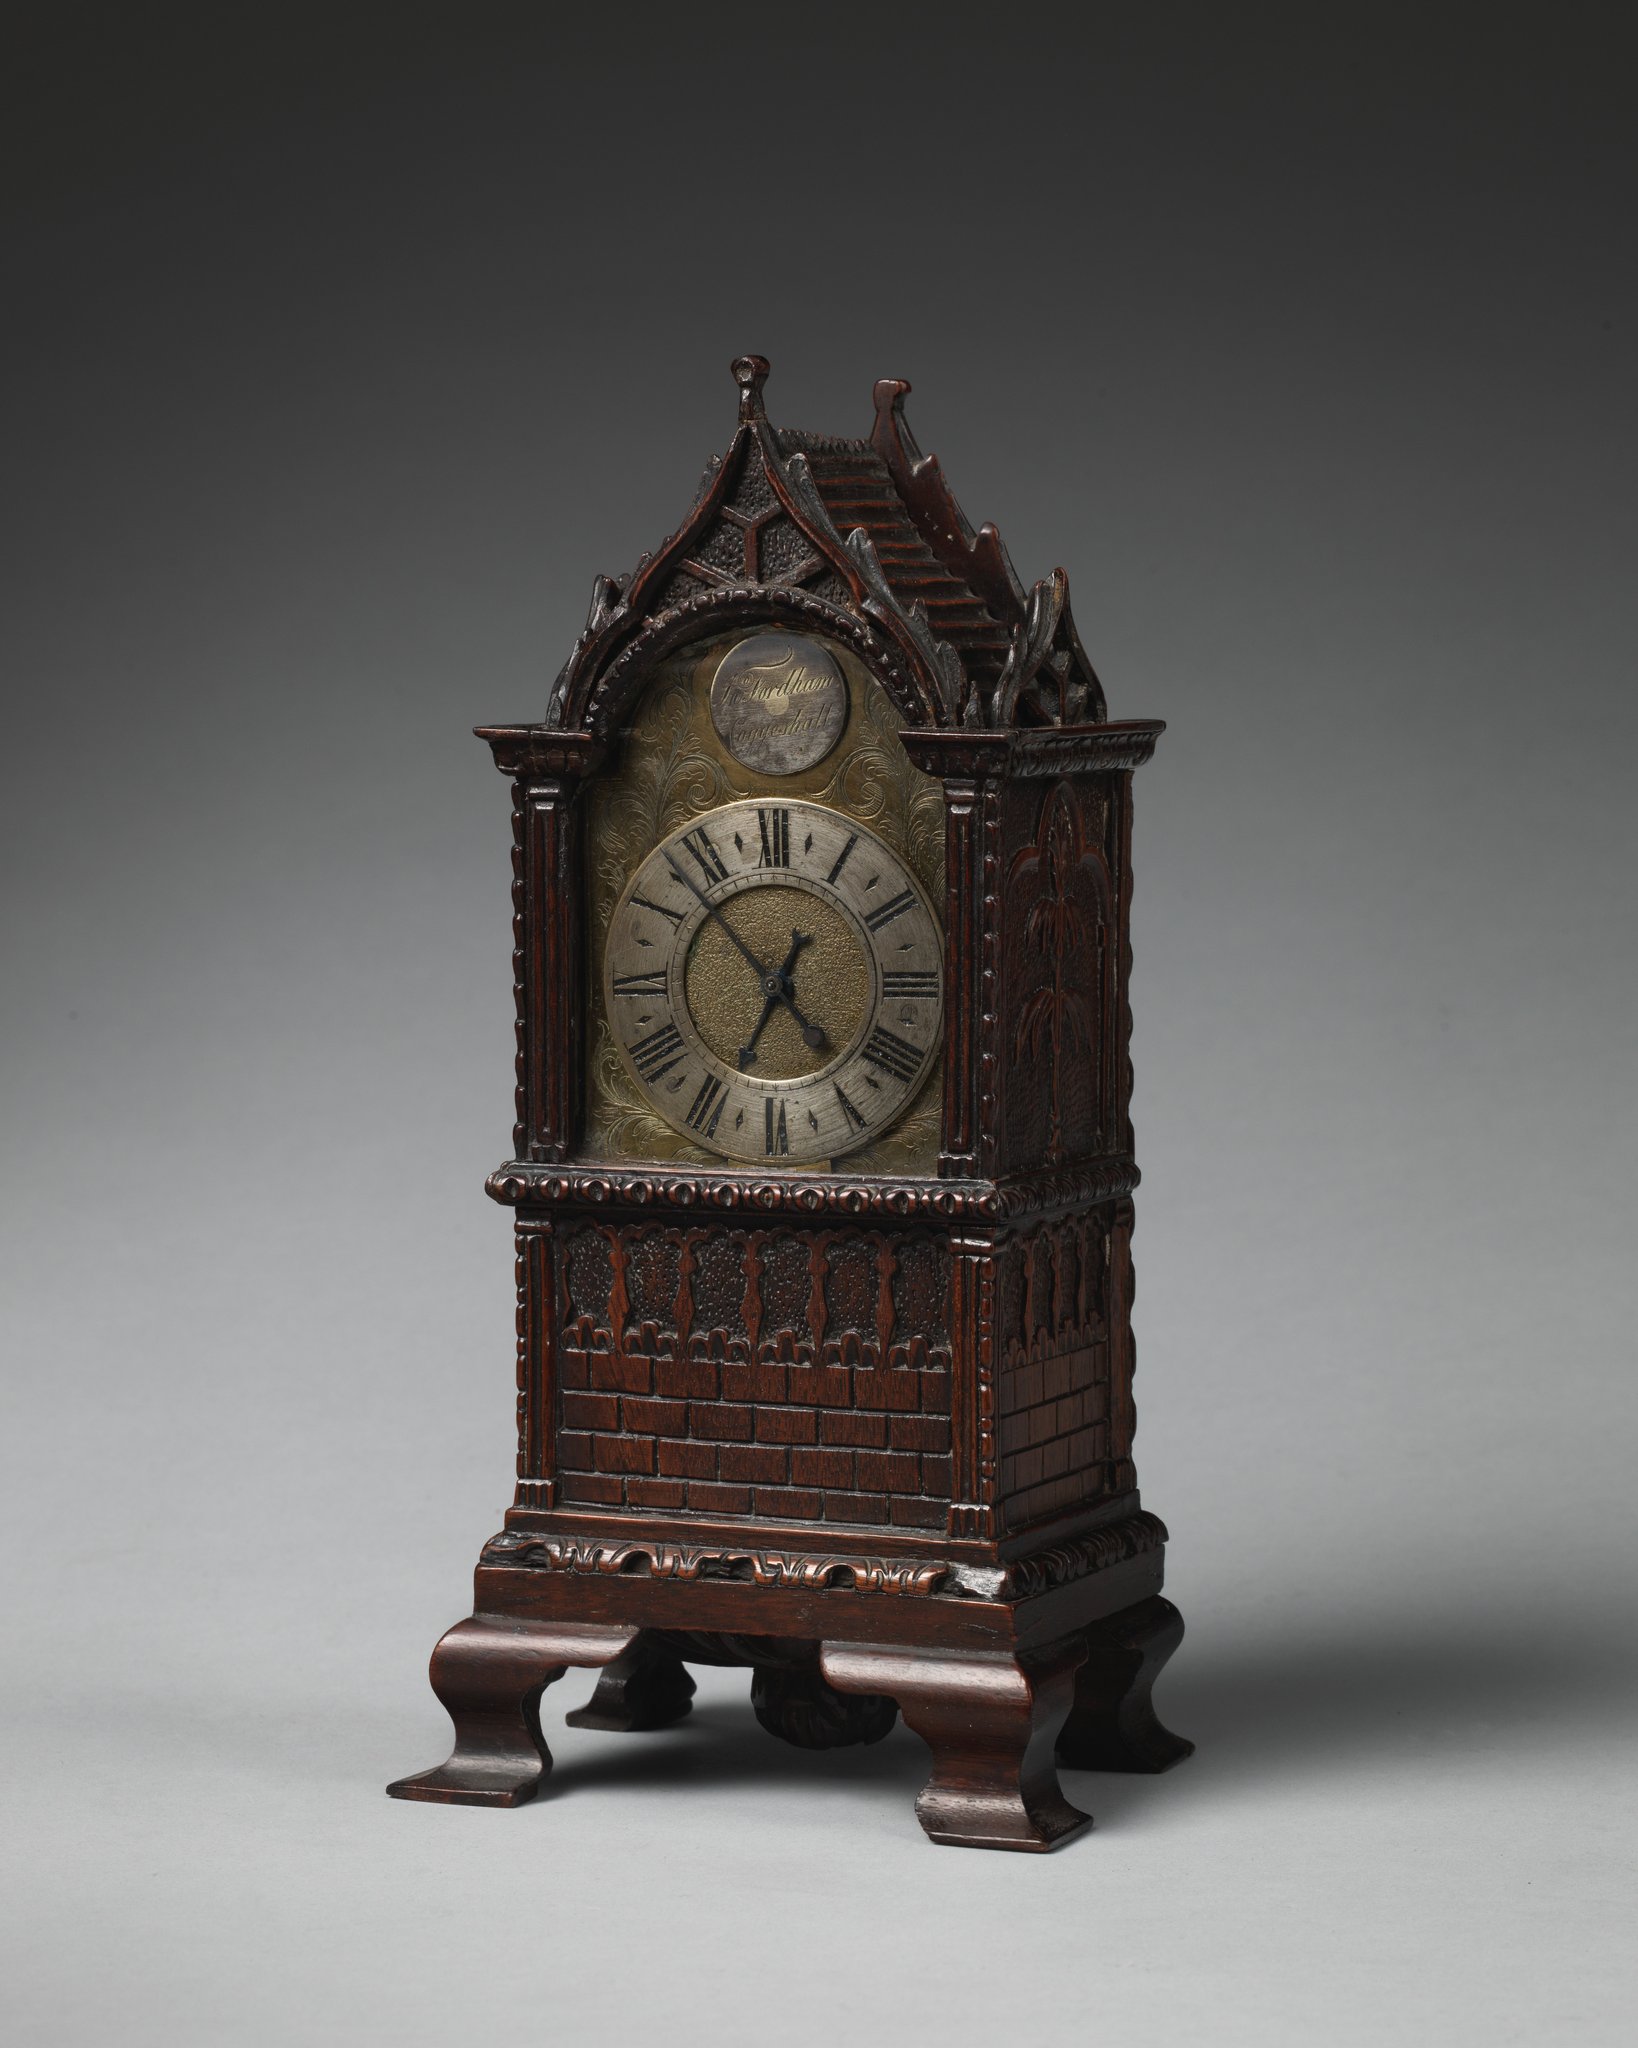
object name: bracket clock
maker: john fordham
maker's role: maker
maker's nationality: british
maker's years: 1705-1805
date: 1755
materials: wood